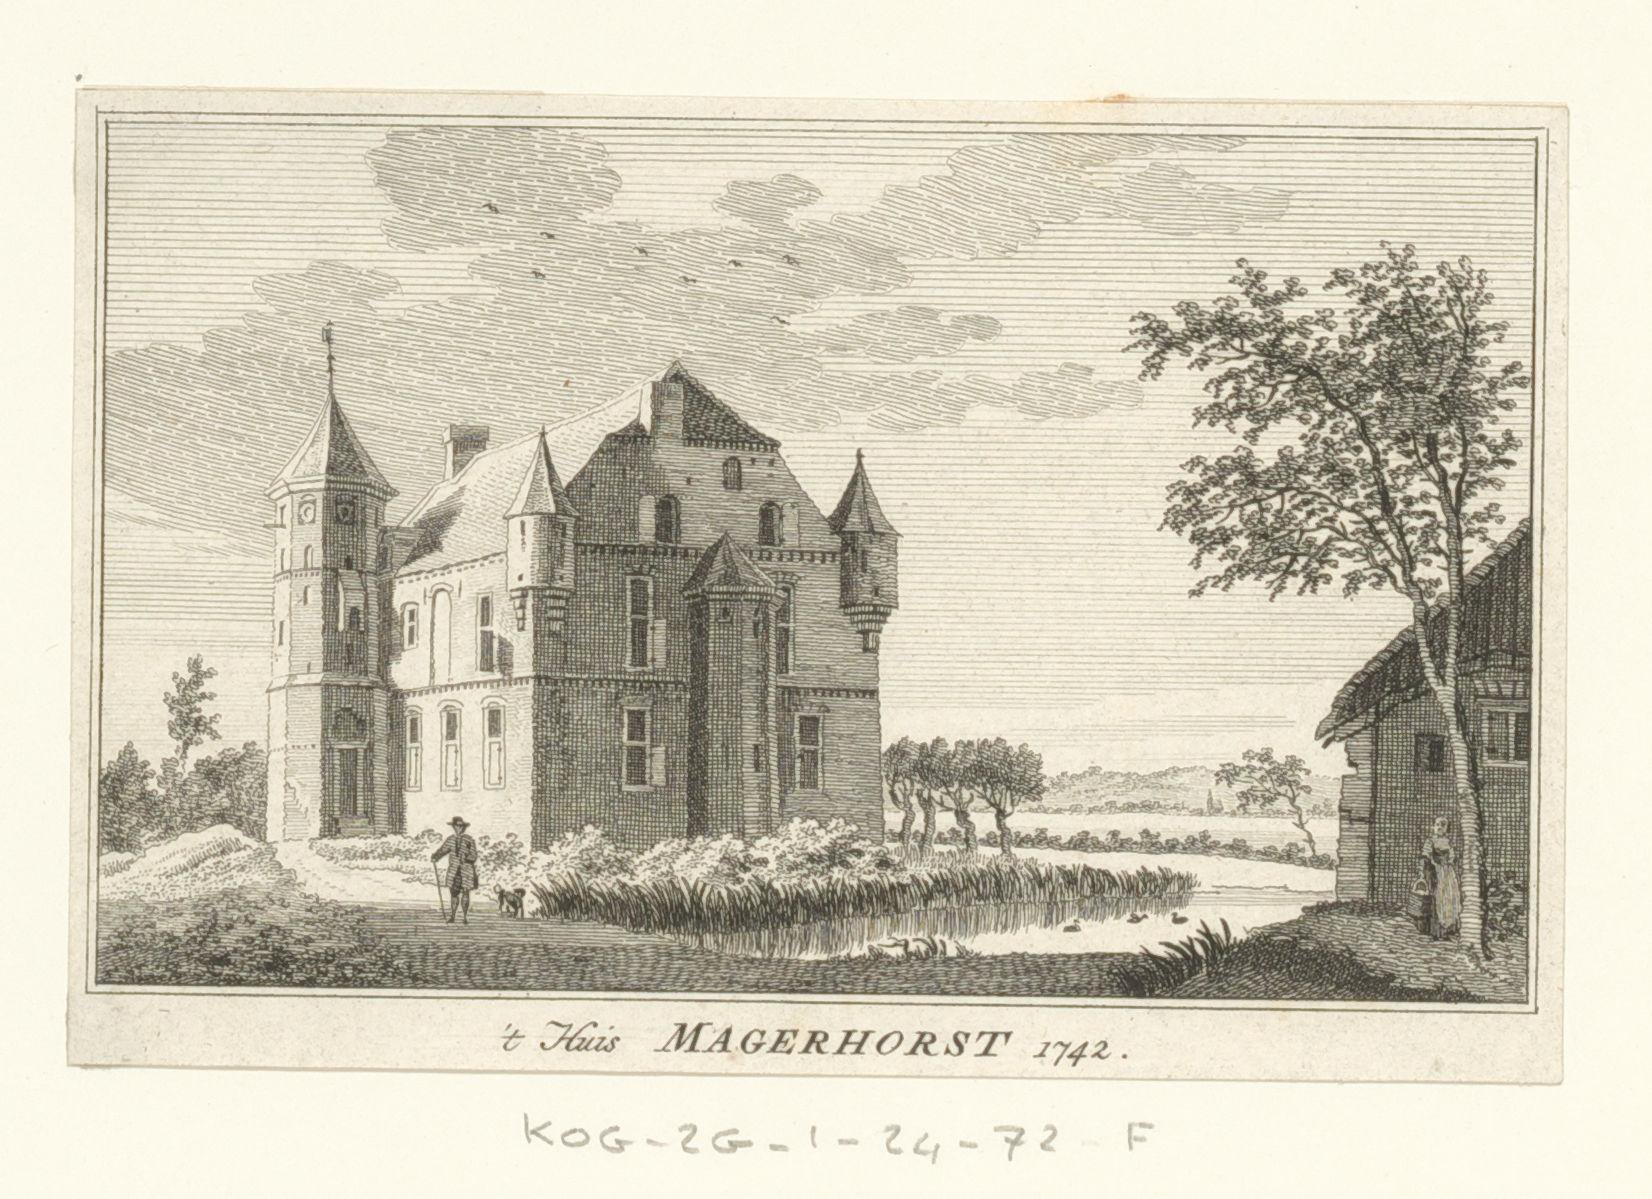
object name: print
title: 't Huis Magerhorst 1742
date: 1762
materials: paper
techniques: etching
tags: city-view, and landscape with man-made constructions, castle, landscape with tower or castle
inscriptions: stamp, collector's mark: Lugt 1641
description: Gezicht op Huis Magerhorst te Duiven. De prent maakt deel uit van een 100-delige serie met gezichten op dorpen en steden te Kleef. Onderwerpsrubrieken binnen de Atlas Zeden en Gewoonten: Zeden en Gewoonten in Engeren Zin, De Woning. Kastelen en buitenplaatsen. Het Kleefse.